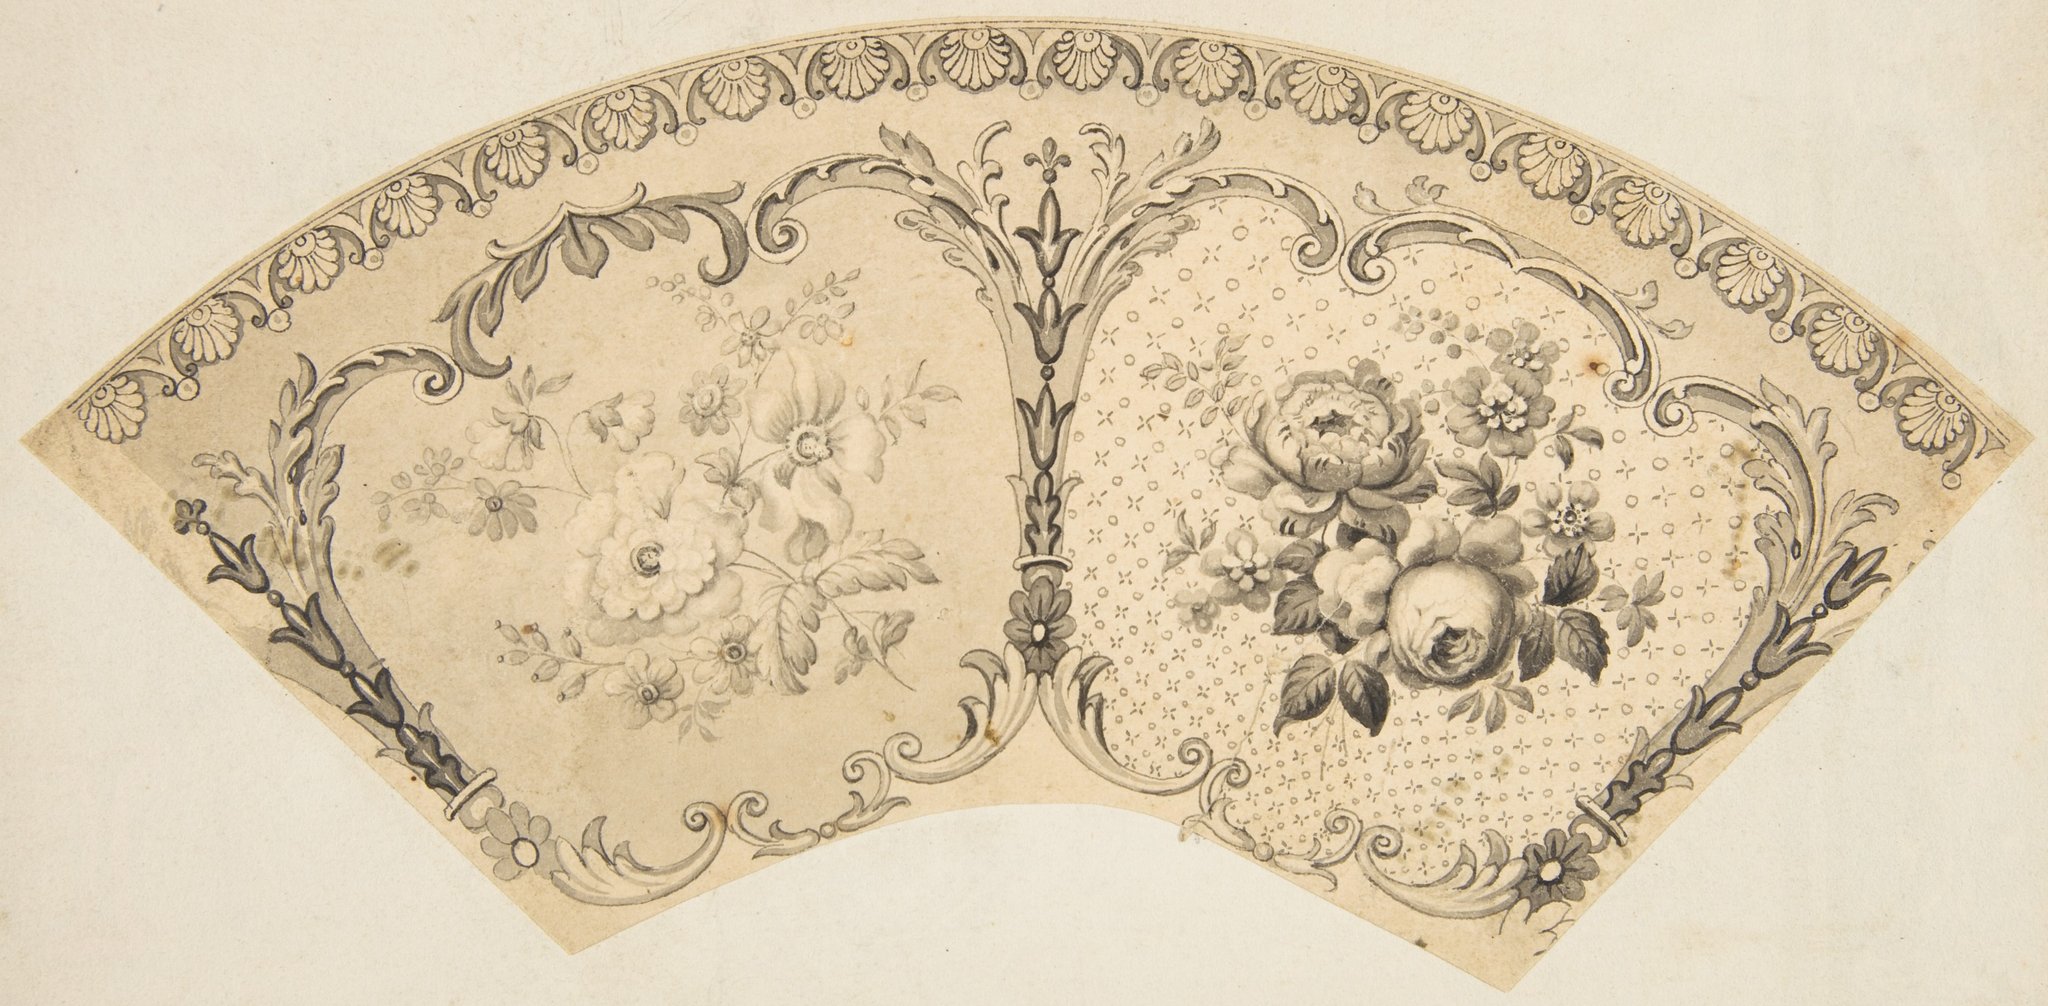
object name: drawing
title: Lace Design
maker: anonymous, french, 19th century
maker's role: artist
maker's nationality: french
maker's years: 1800-1900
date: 1801-1900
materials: ink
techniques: pen, wash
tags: flowers,leaves